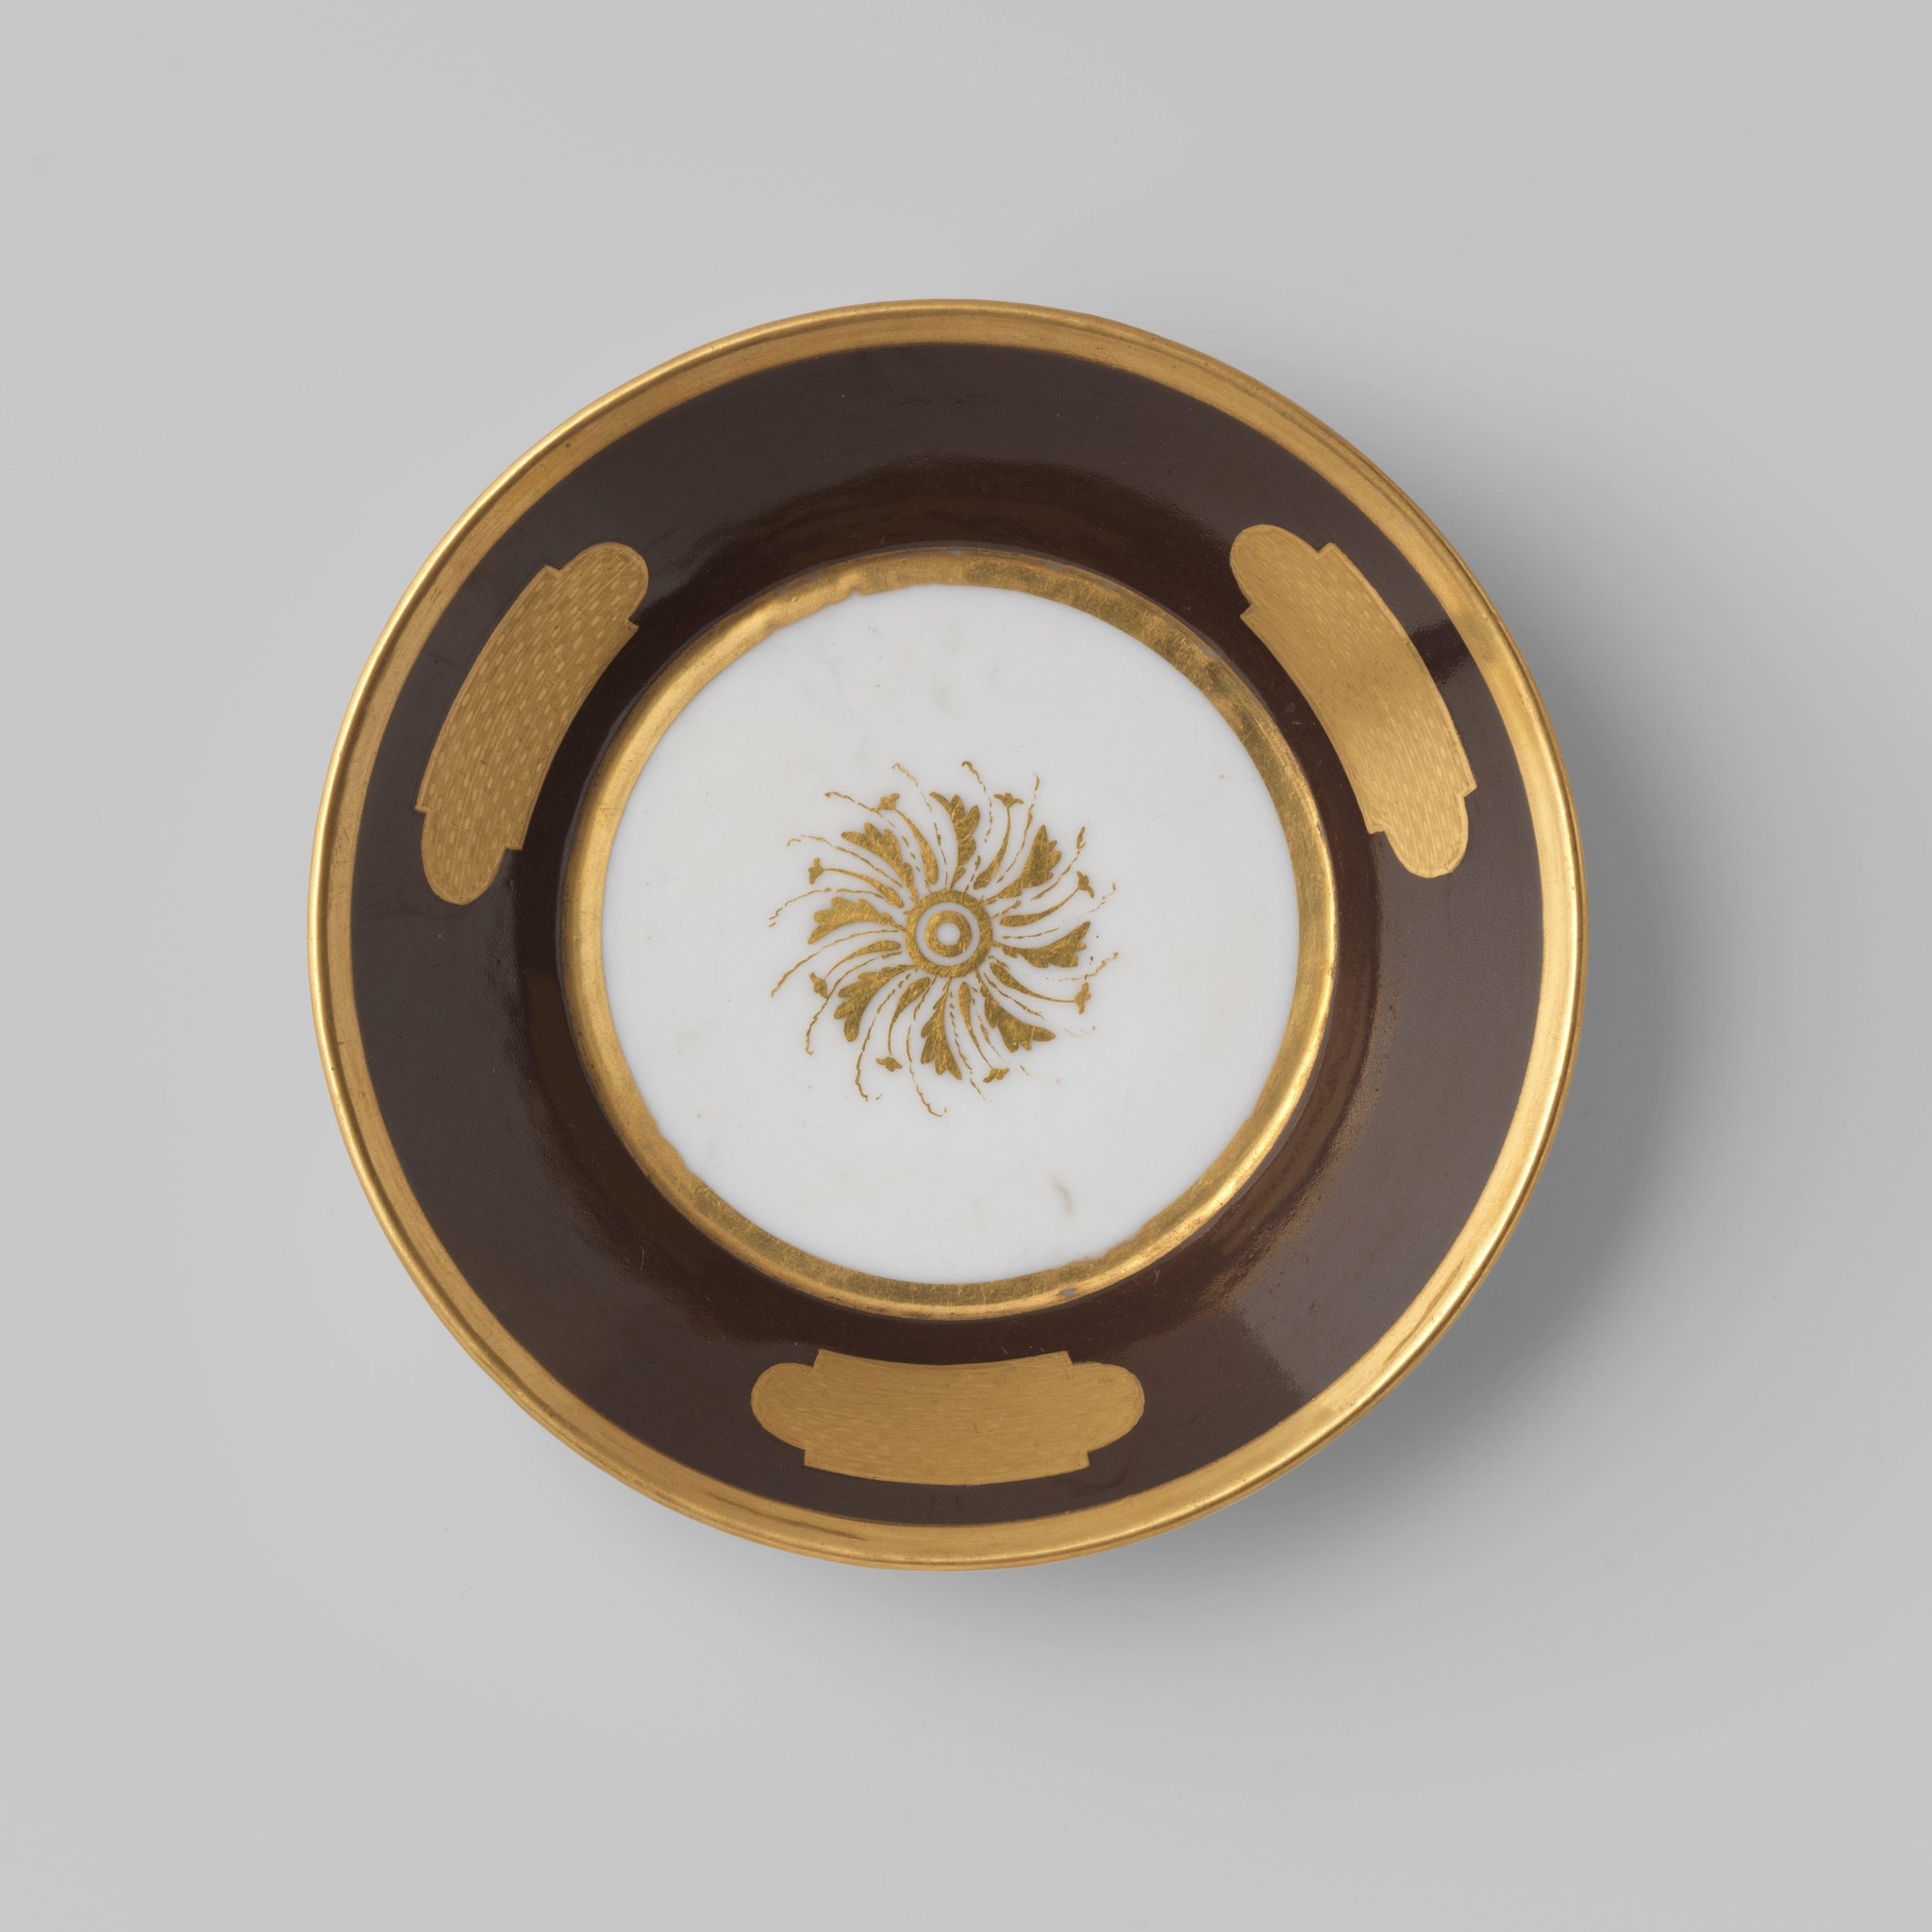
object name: platter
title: Saucer with a roundel and golden panels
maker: Anonymous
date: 1790-1800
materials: glaze, gold, paint, porcelain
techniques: firing, forming, gilding, turning, vitrification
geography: france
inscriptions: mark: ‘I’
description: Schotel van porselein met een rechte wand, beschilderd op het glazuur in bruin en goud. Op het plat een rozet in een gouden medaillon. De wand met drie gouden cartouches op een donkerbruine achtergrond. Gemerkt op de onderzijde met I.